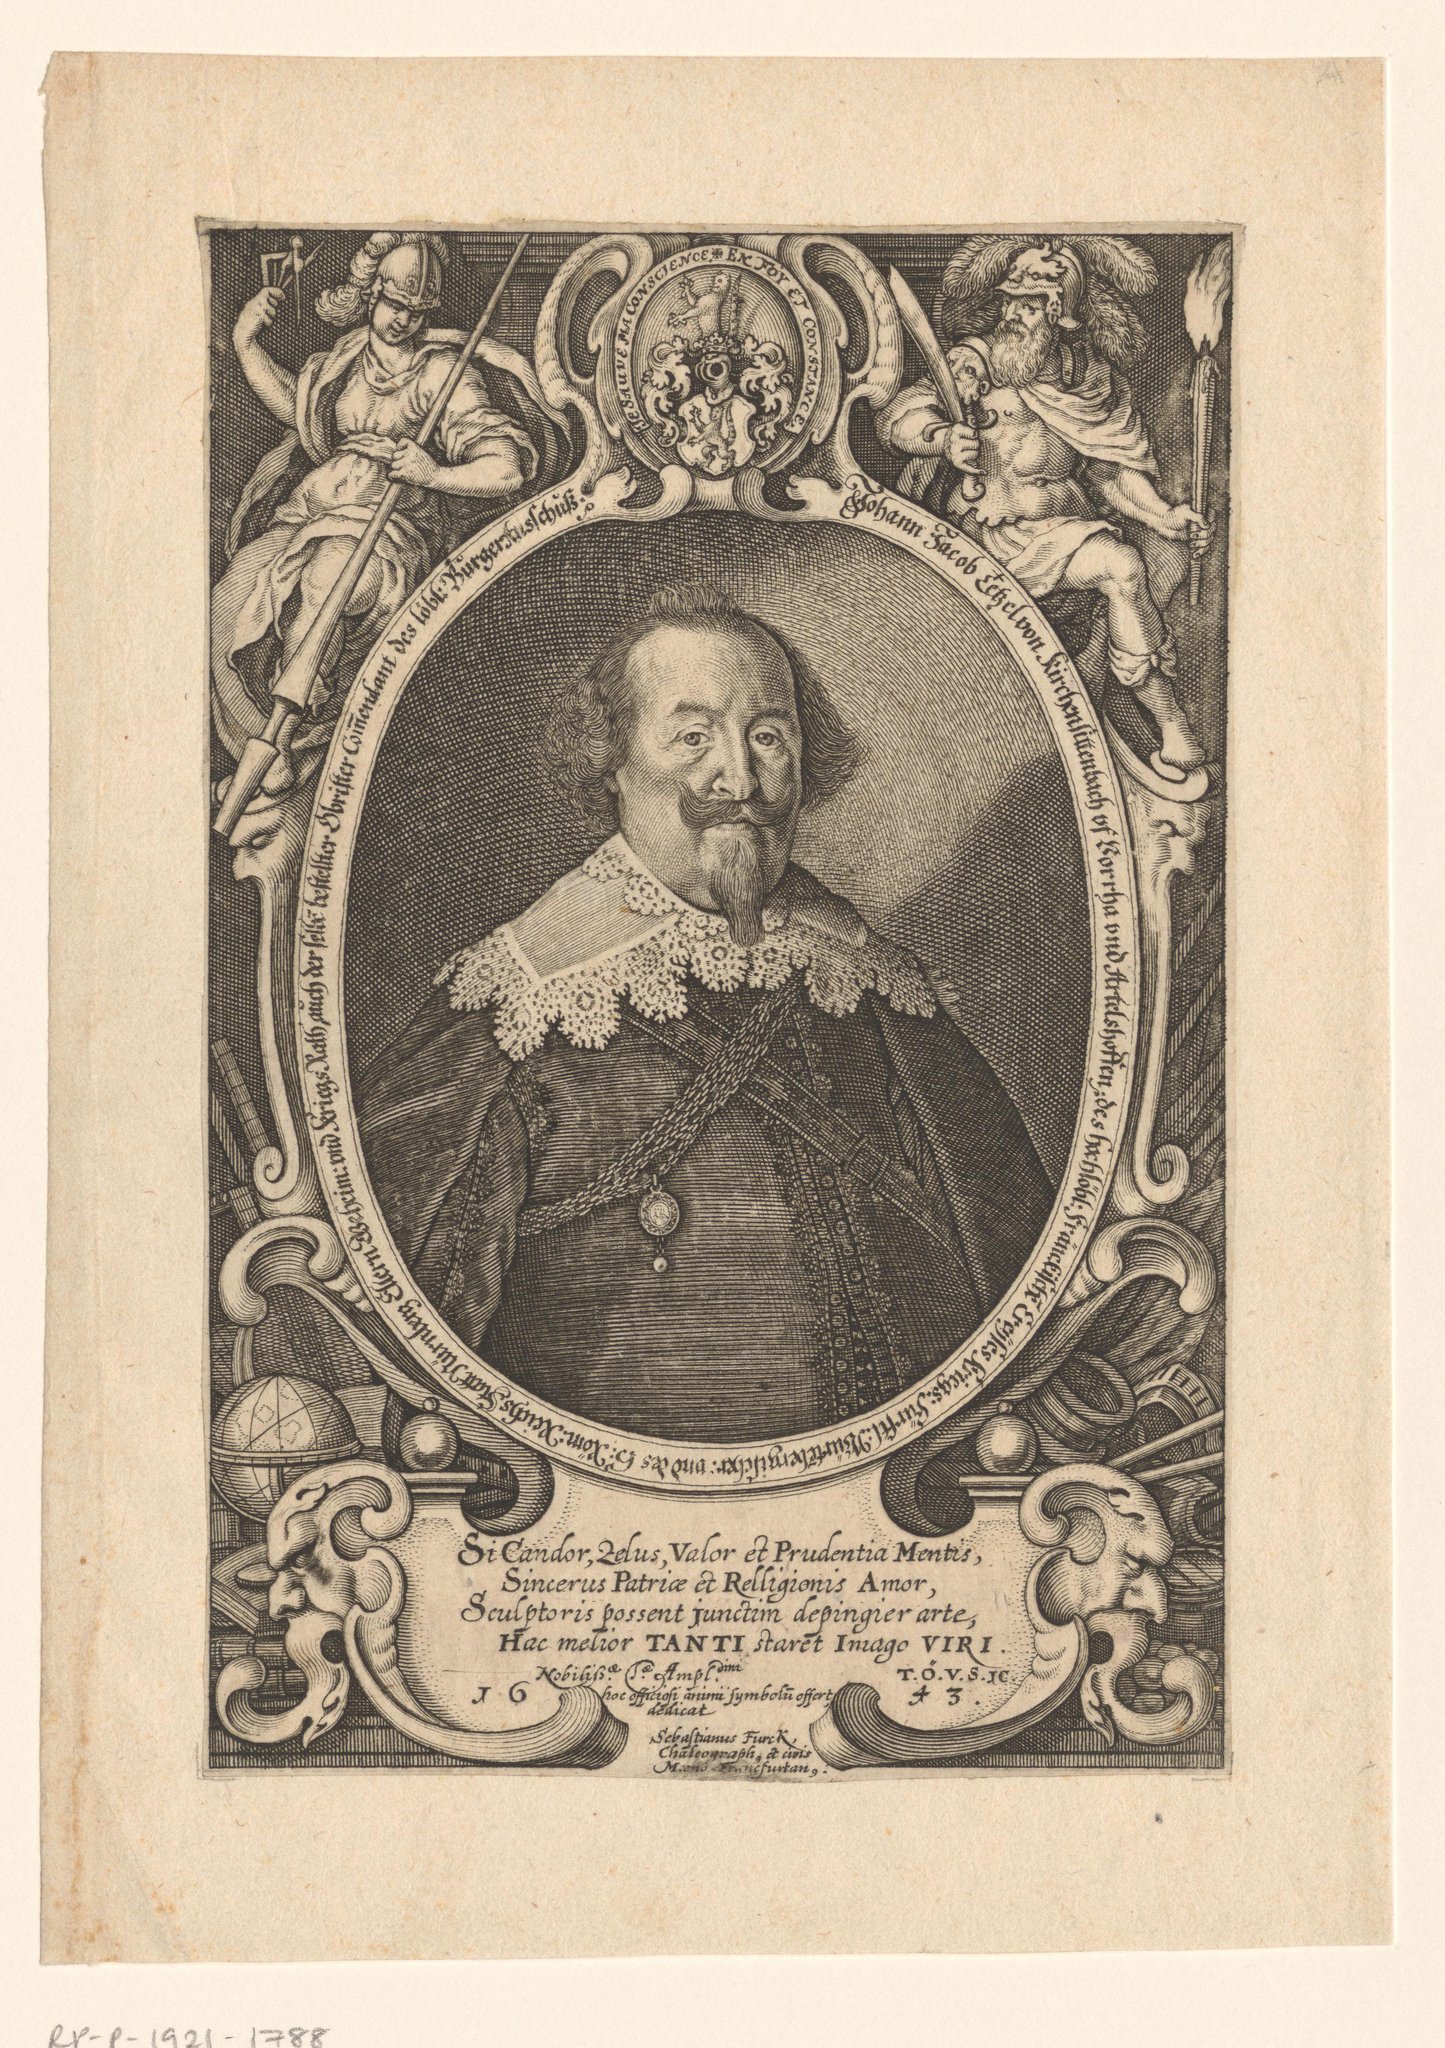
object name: print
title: Portret van Johann Jacob Tetzel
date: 1643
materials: paper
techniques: engraving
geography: frankfurt am main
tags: politician, historical persons, armorial bearing, heraldry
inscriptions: collector's mark: Lugt 2233